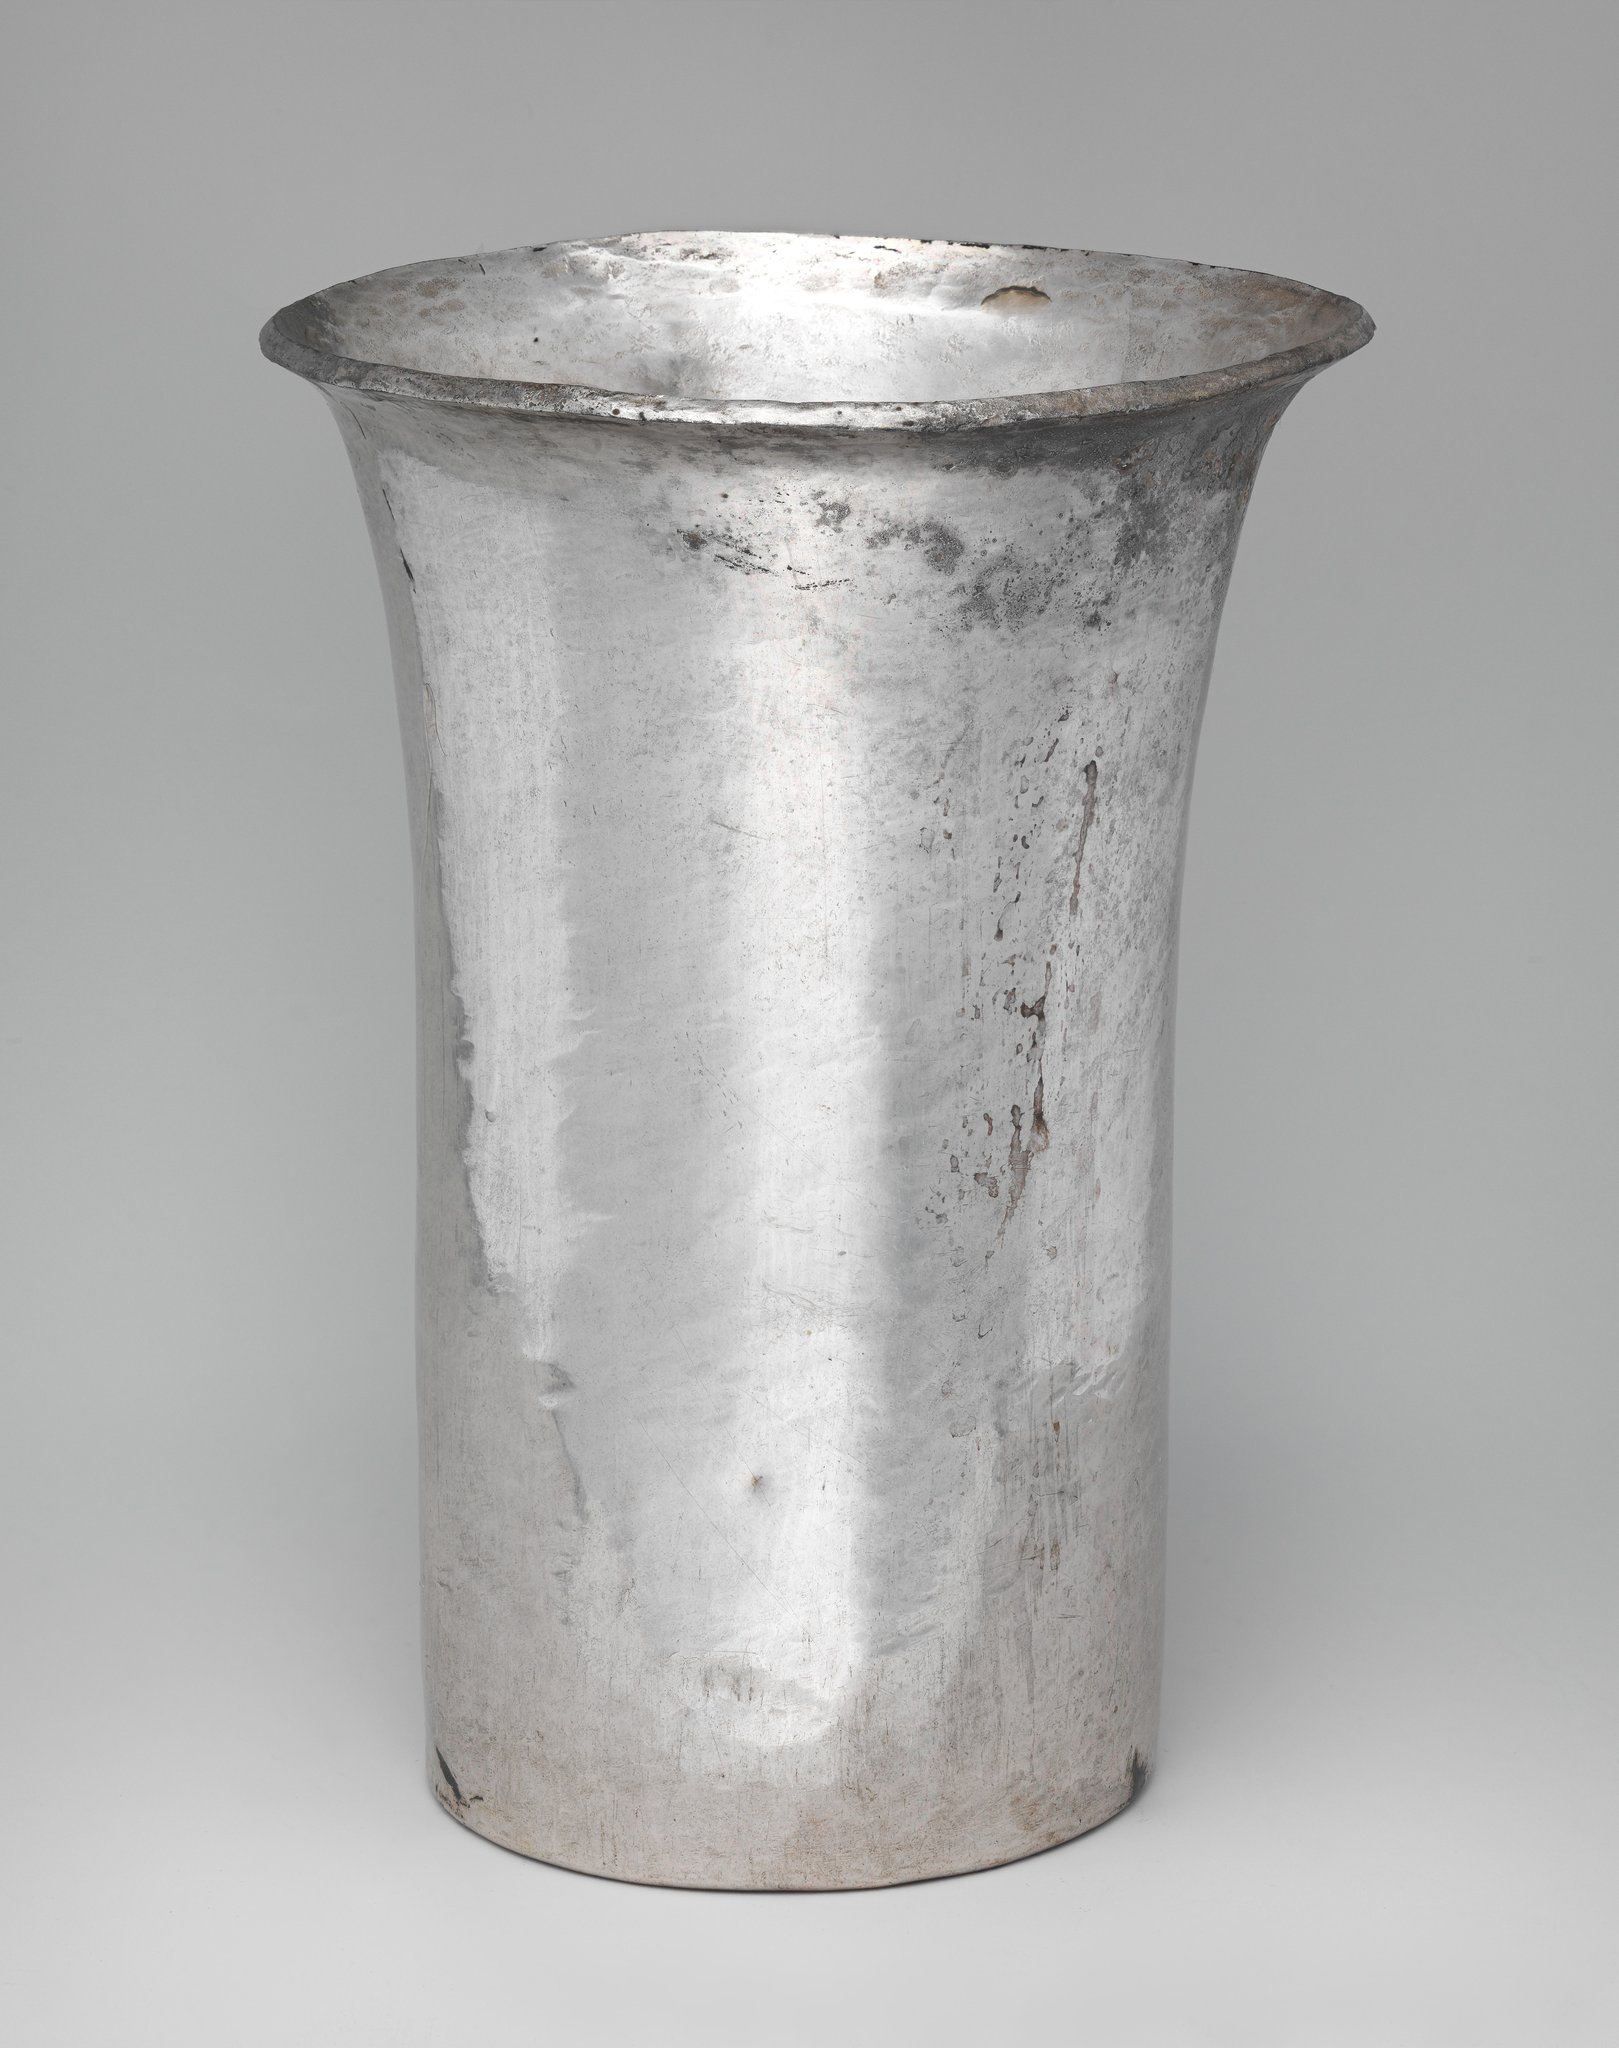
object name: beaker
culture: chimú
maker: chimú artist(s)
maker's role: artist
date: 1100-1470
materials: silver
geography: peru